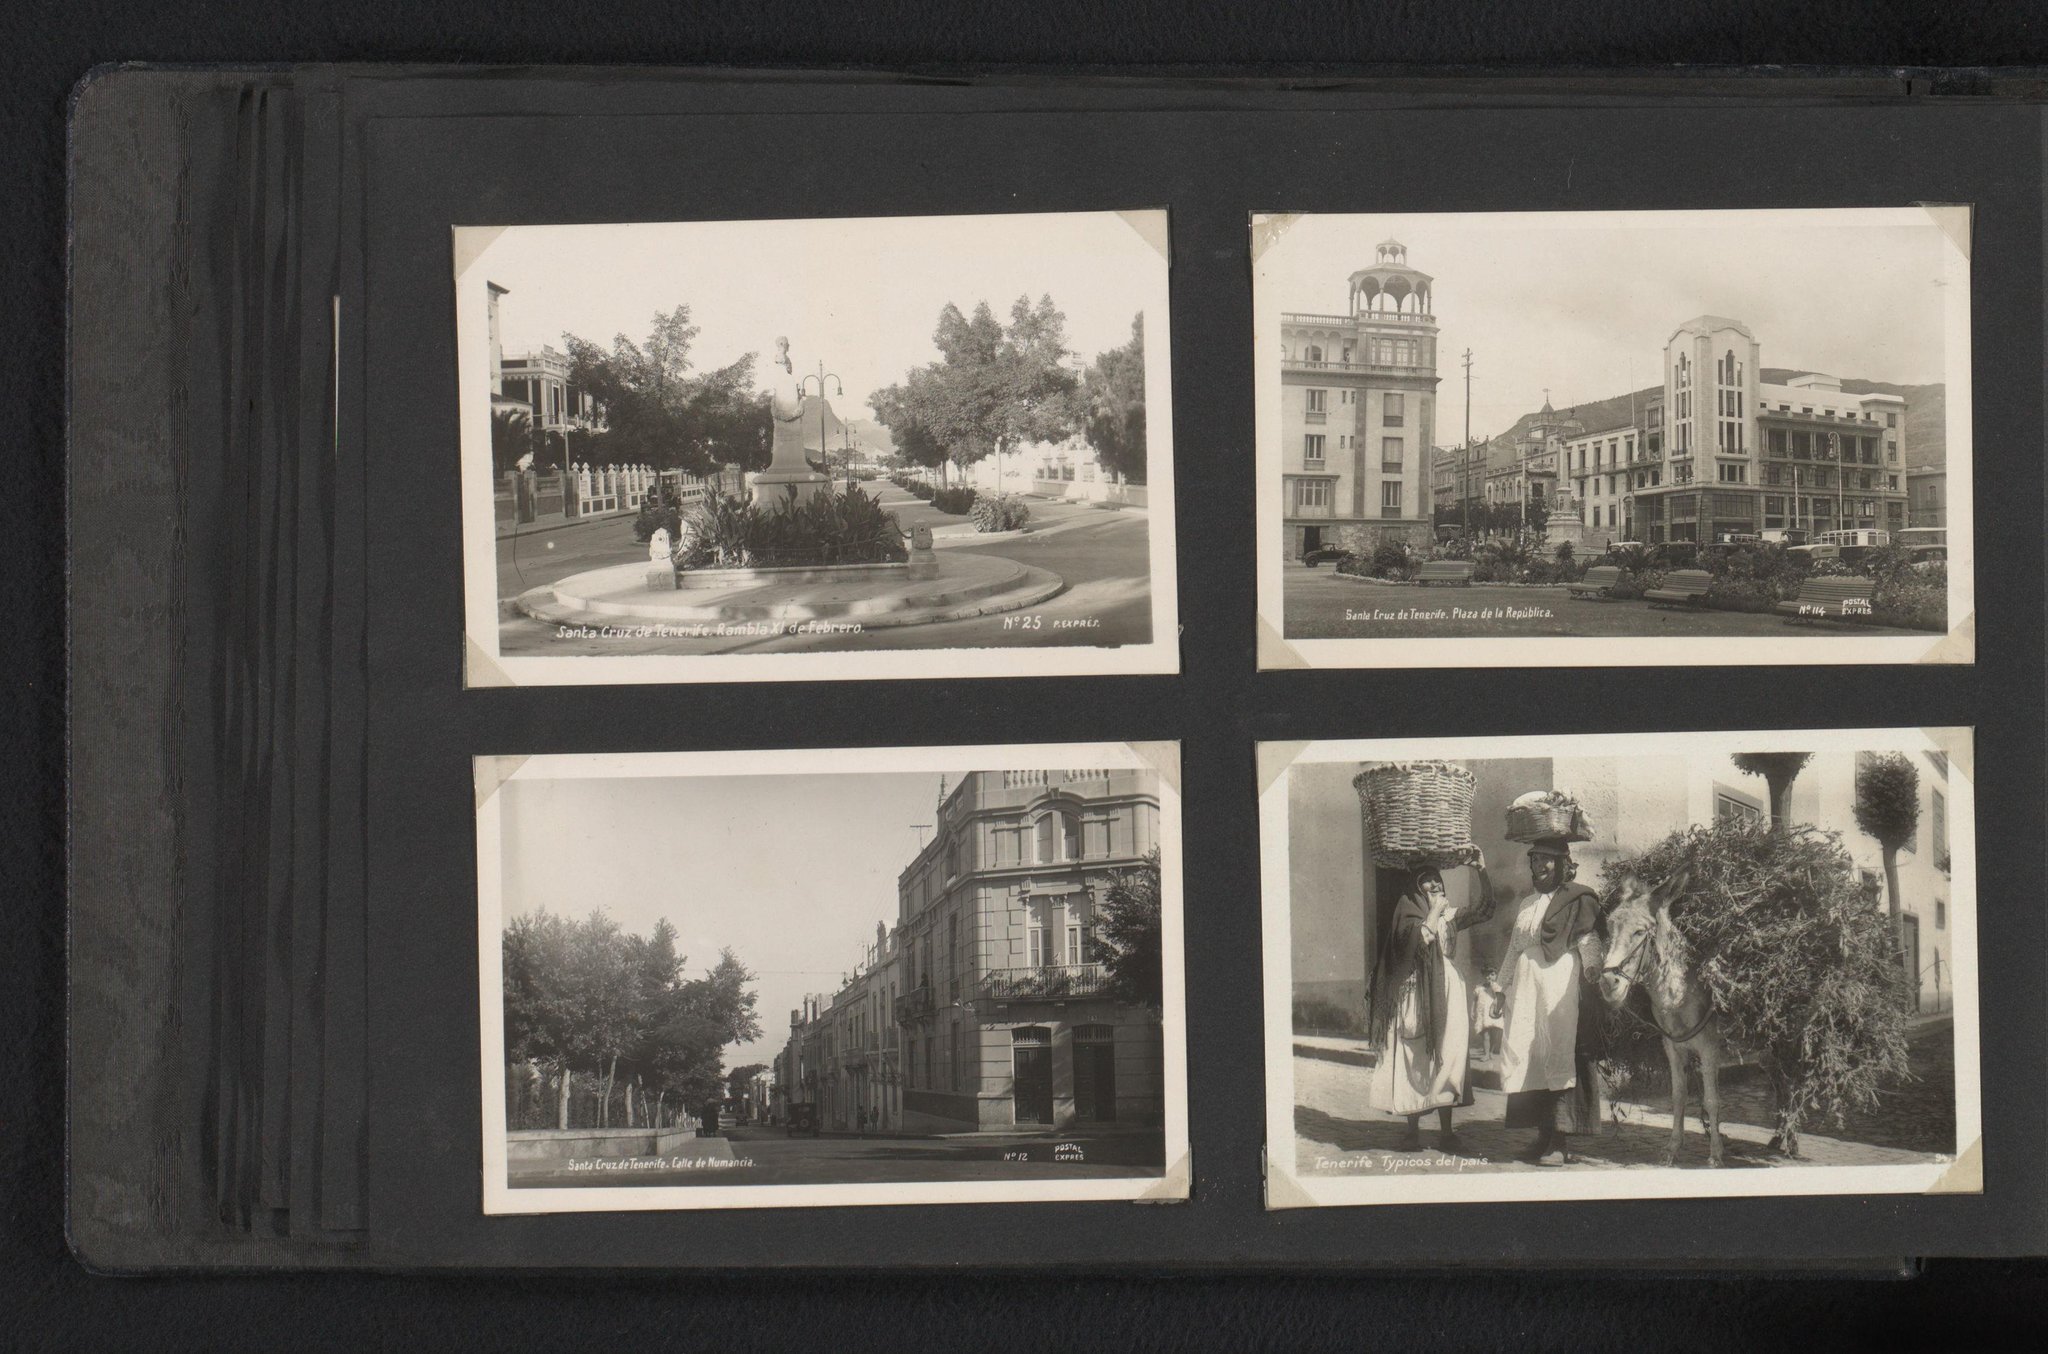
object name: photograph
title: Vier fotografische prentbriefkaarten van Santa Cruz de Tenerife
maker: Anonymous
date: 1933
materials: paper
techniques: gelatin silver print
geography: santa cruz de tenerife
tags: ass, donkey, street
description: Deze foto's maken deel uit van een album.